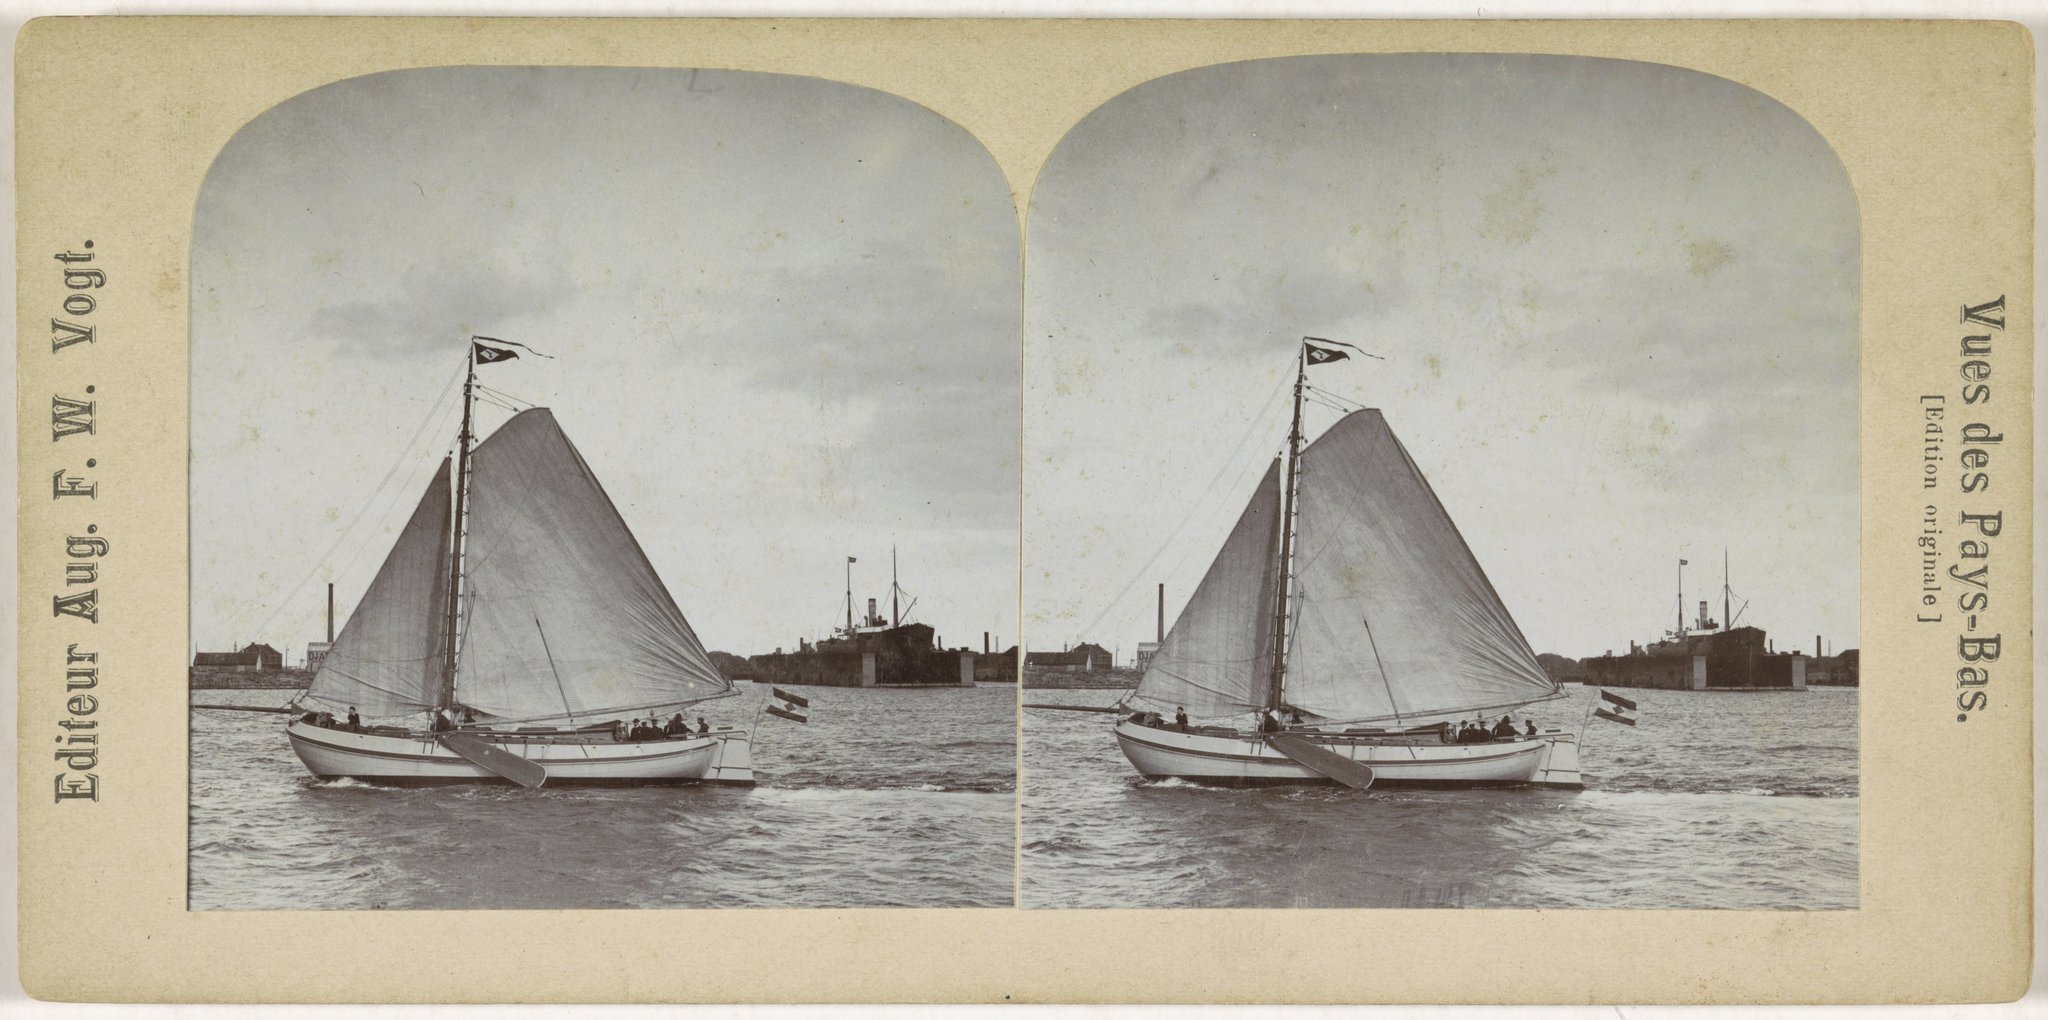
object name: stereograph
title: Vues des Pays-Bas.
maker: august frederik willem vogt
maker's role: fotograaf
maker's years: 1871-1922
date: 1870-1920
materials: cardboard, paper, photographic support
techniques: gelatin silver print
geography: new york city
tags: ij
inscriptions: number: ‘25’, annotation: ‘Op het IJ.’, inscription: ‘Vues des Pays-Bas. [Edition originale]’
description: Lemsteraak op het IJ. In de top van de mast de verenigingsvlag van Zeilvereniging Het Y. Op het roer wappert de vlag van een andere Amsterdamse zeilvereniging, de Koninklijke Nederlandse Zeil- en Roeivereniging. Rechts op de achtergrond een schip in een droogdok.